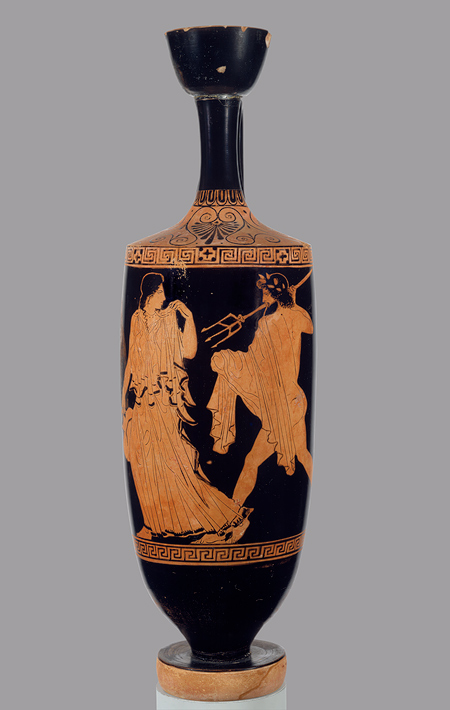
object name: lekythos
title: Terracotta lekythos (oil flask)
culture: greek, attic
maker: phiale painter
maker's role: artist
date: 440 BCE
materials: terracotta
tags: men,women,poseidon